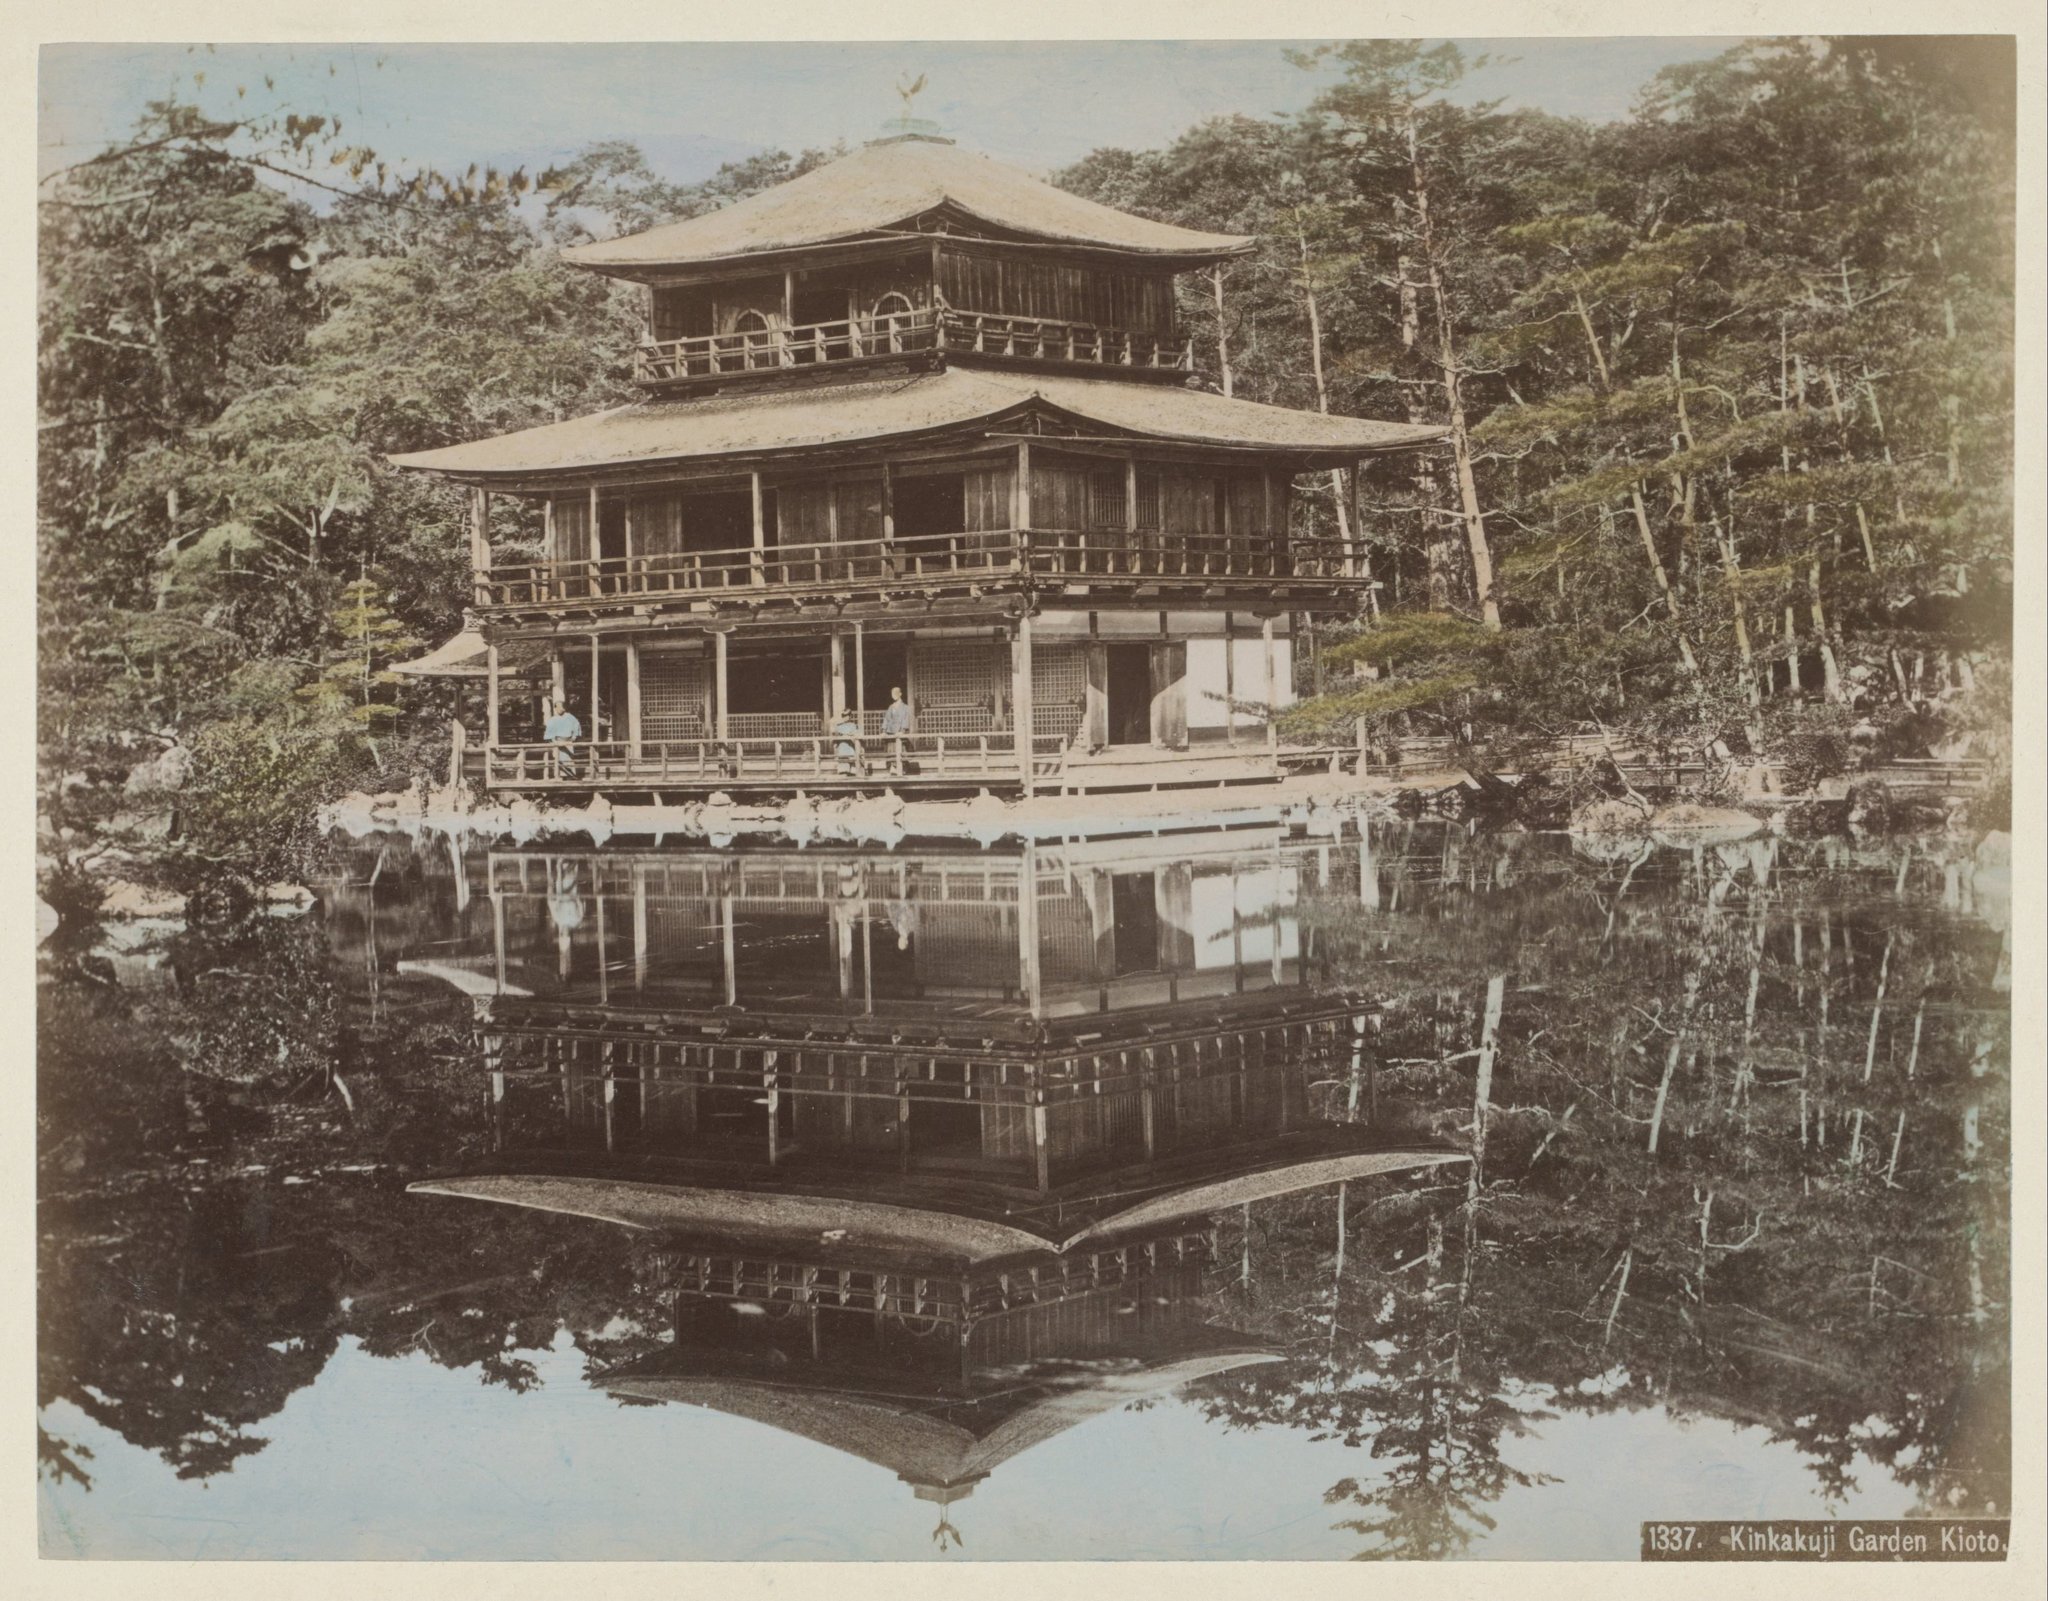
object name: photograph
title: Exterieur van de Gouden Paviljoen Tempel in Kyoto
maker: Anonymous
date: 1870-1900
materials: paper, photographic support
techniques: albumen print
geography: kyoto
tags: trees, travelling; tourism, temple, shrine ~ islam, mohammedanism, pond, kyoto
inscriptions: negative number: ‘1337’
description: Onderdeel van Fotoalbum met 50 foto's van bezienswaardigheden in Japan.